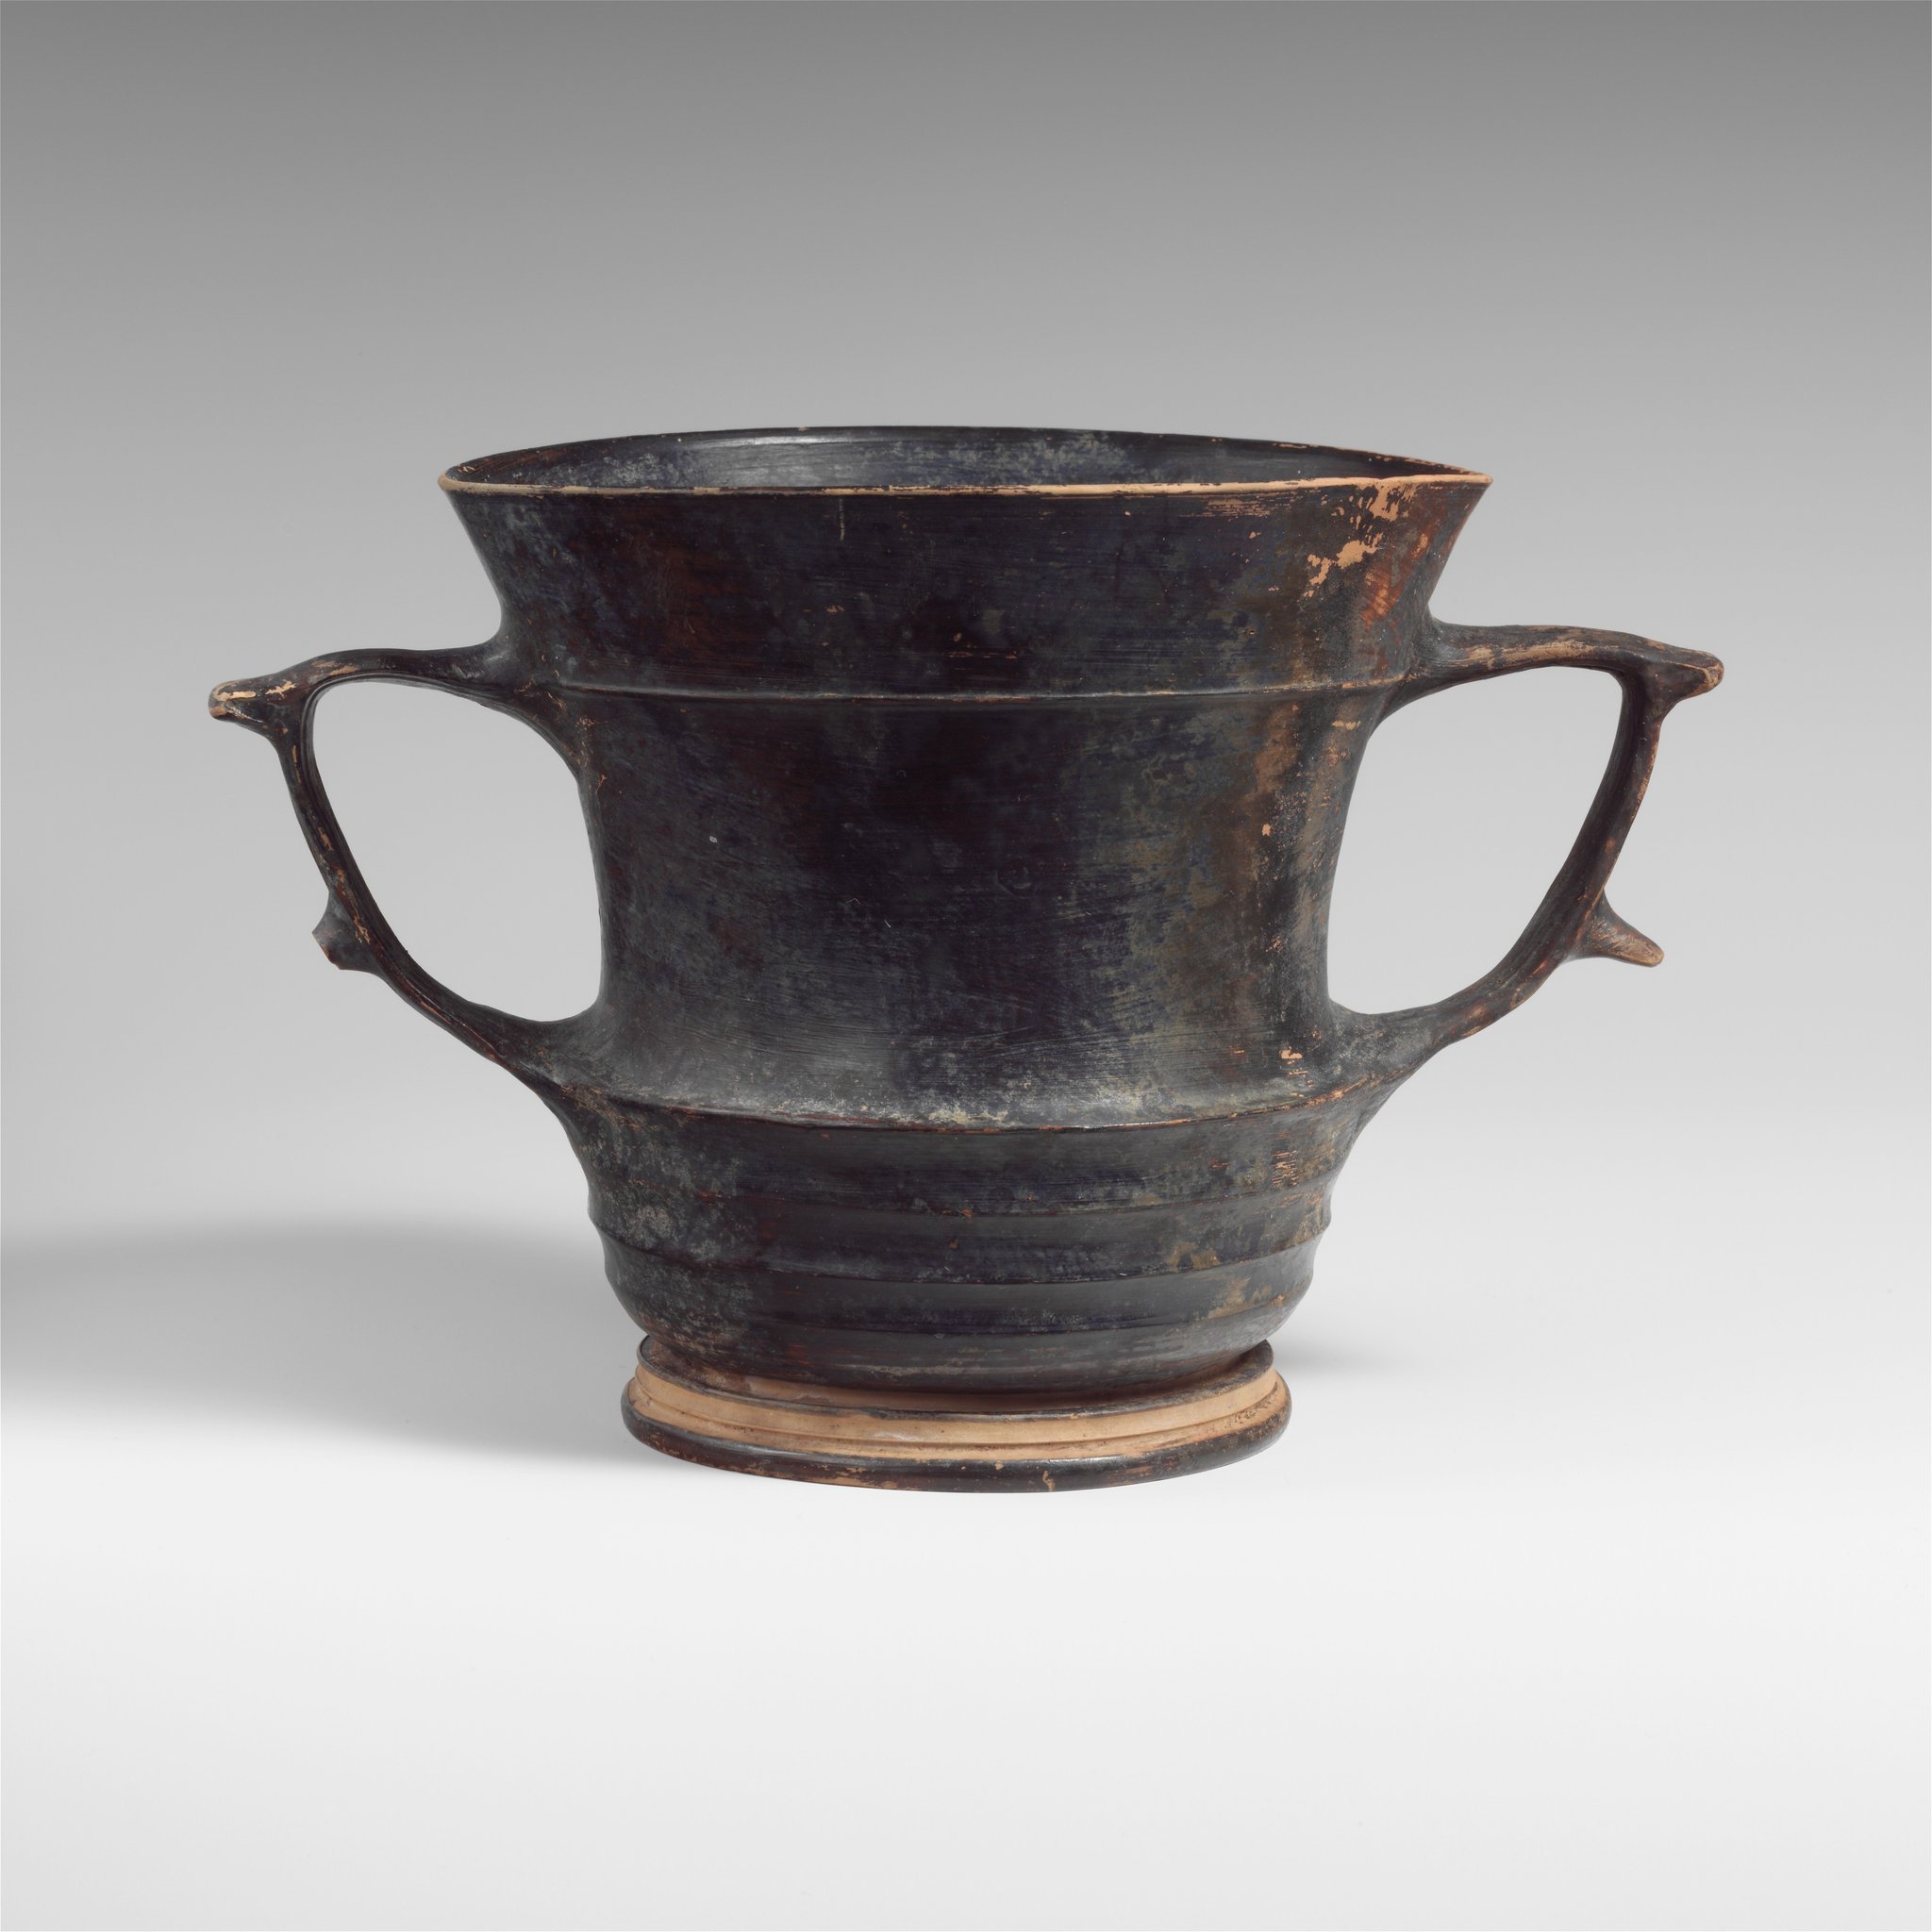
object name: kantharos, karchesion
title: Terracotta kantharos: karchesion (deep cylindrical drinking cup)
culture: greek, boeotian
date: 500-401 BCE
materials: terracotta